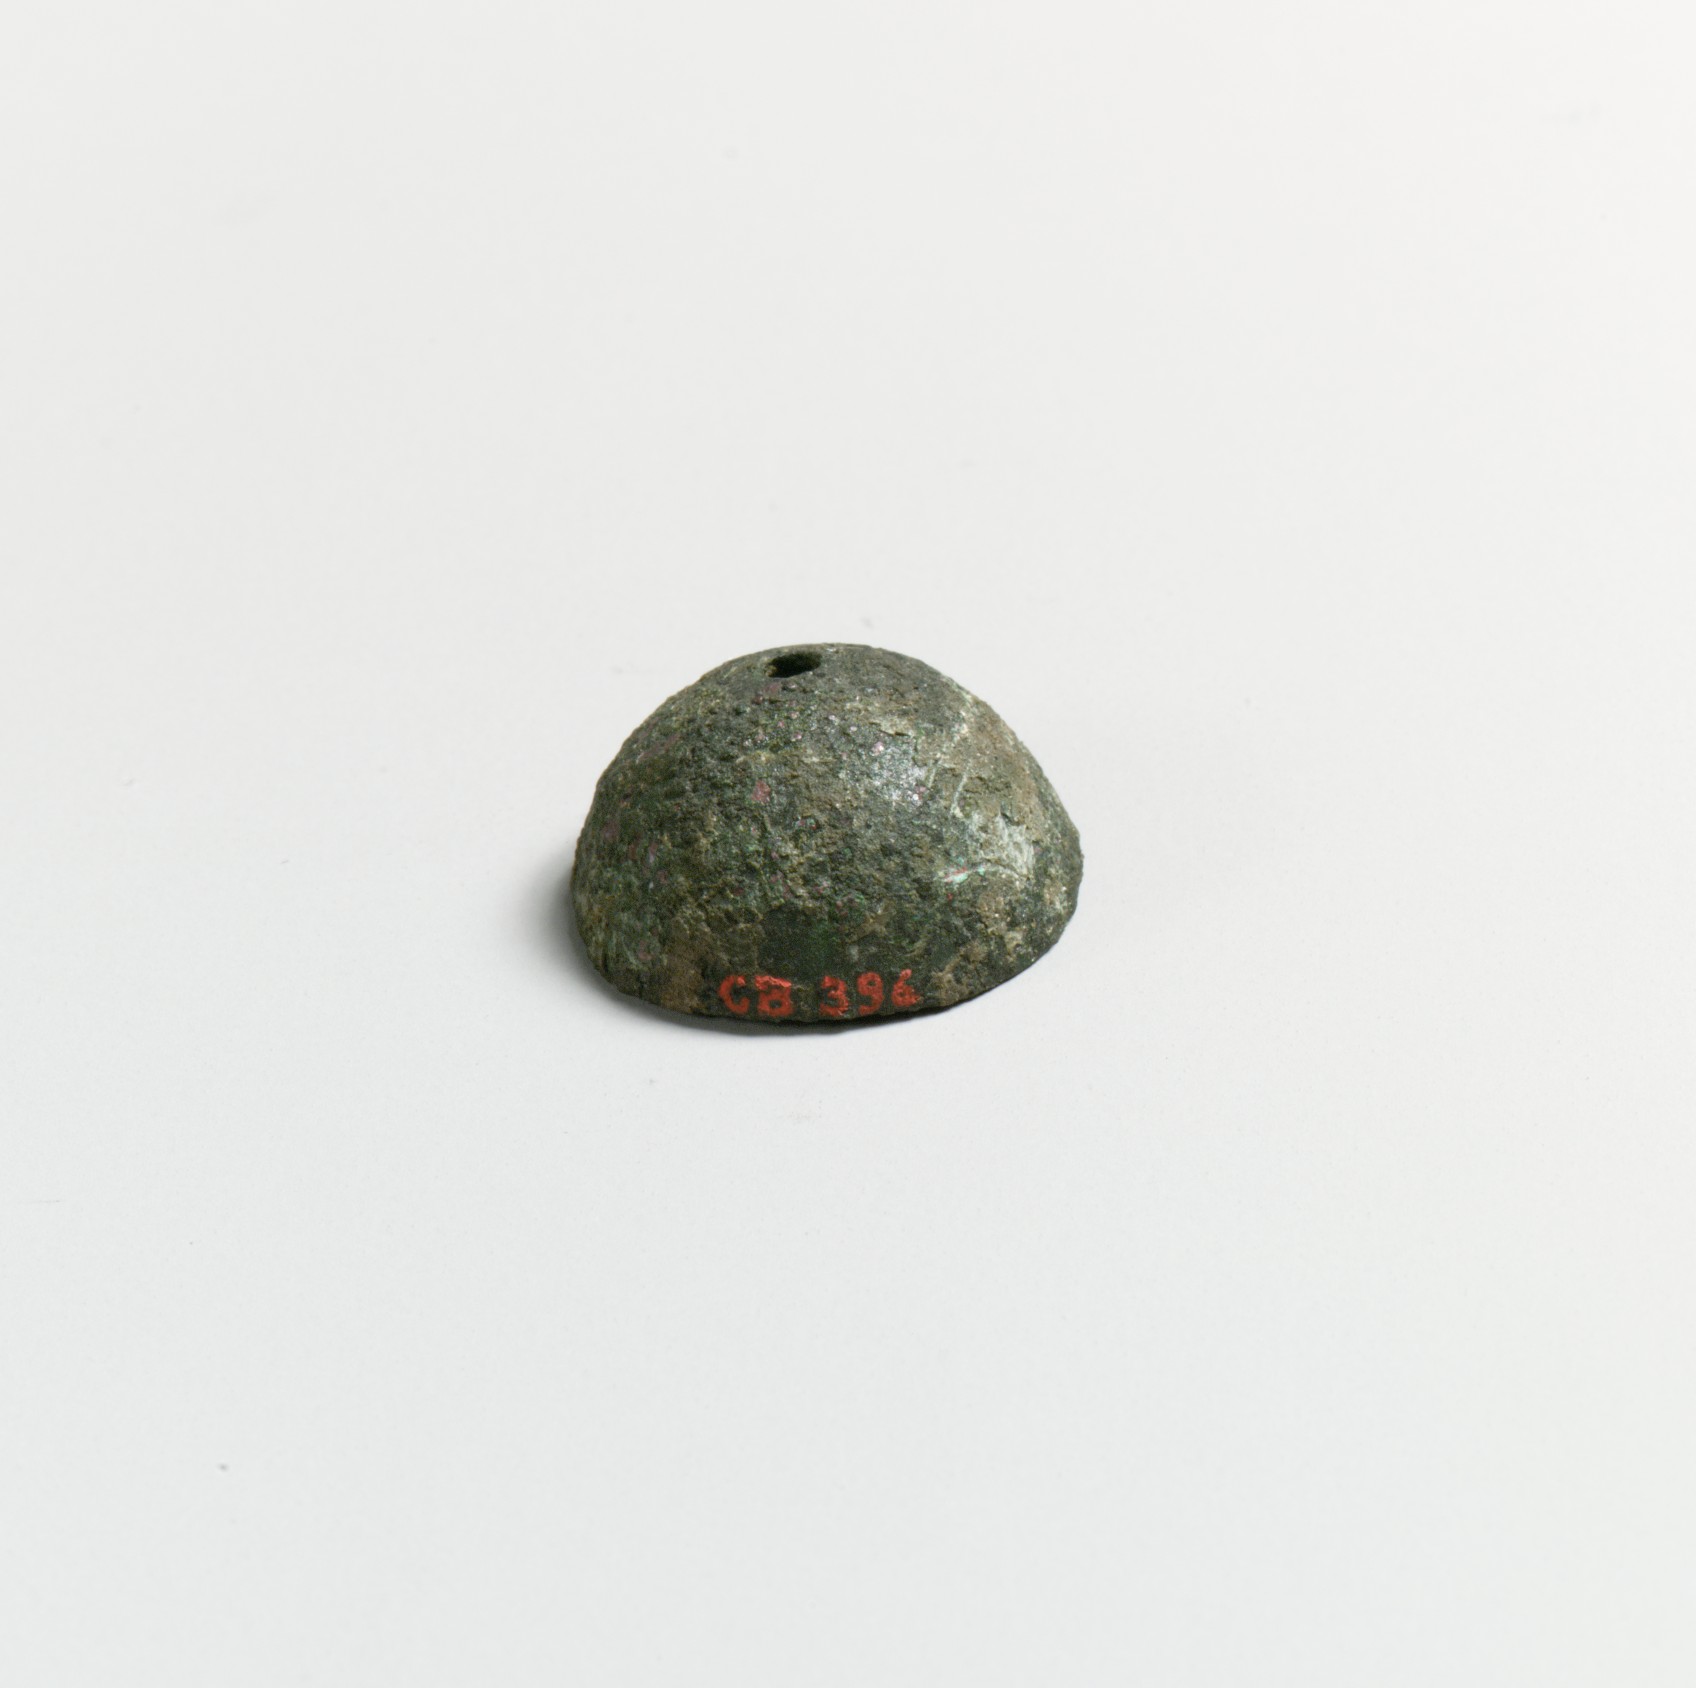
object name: bell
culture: cypriot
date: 400-301 BCE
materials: bronze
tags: musical instruments